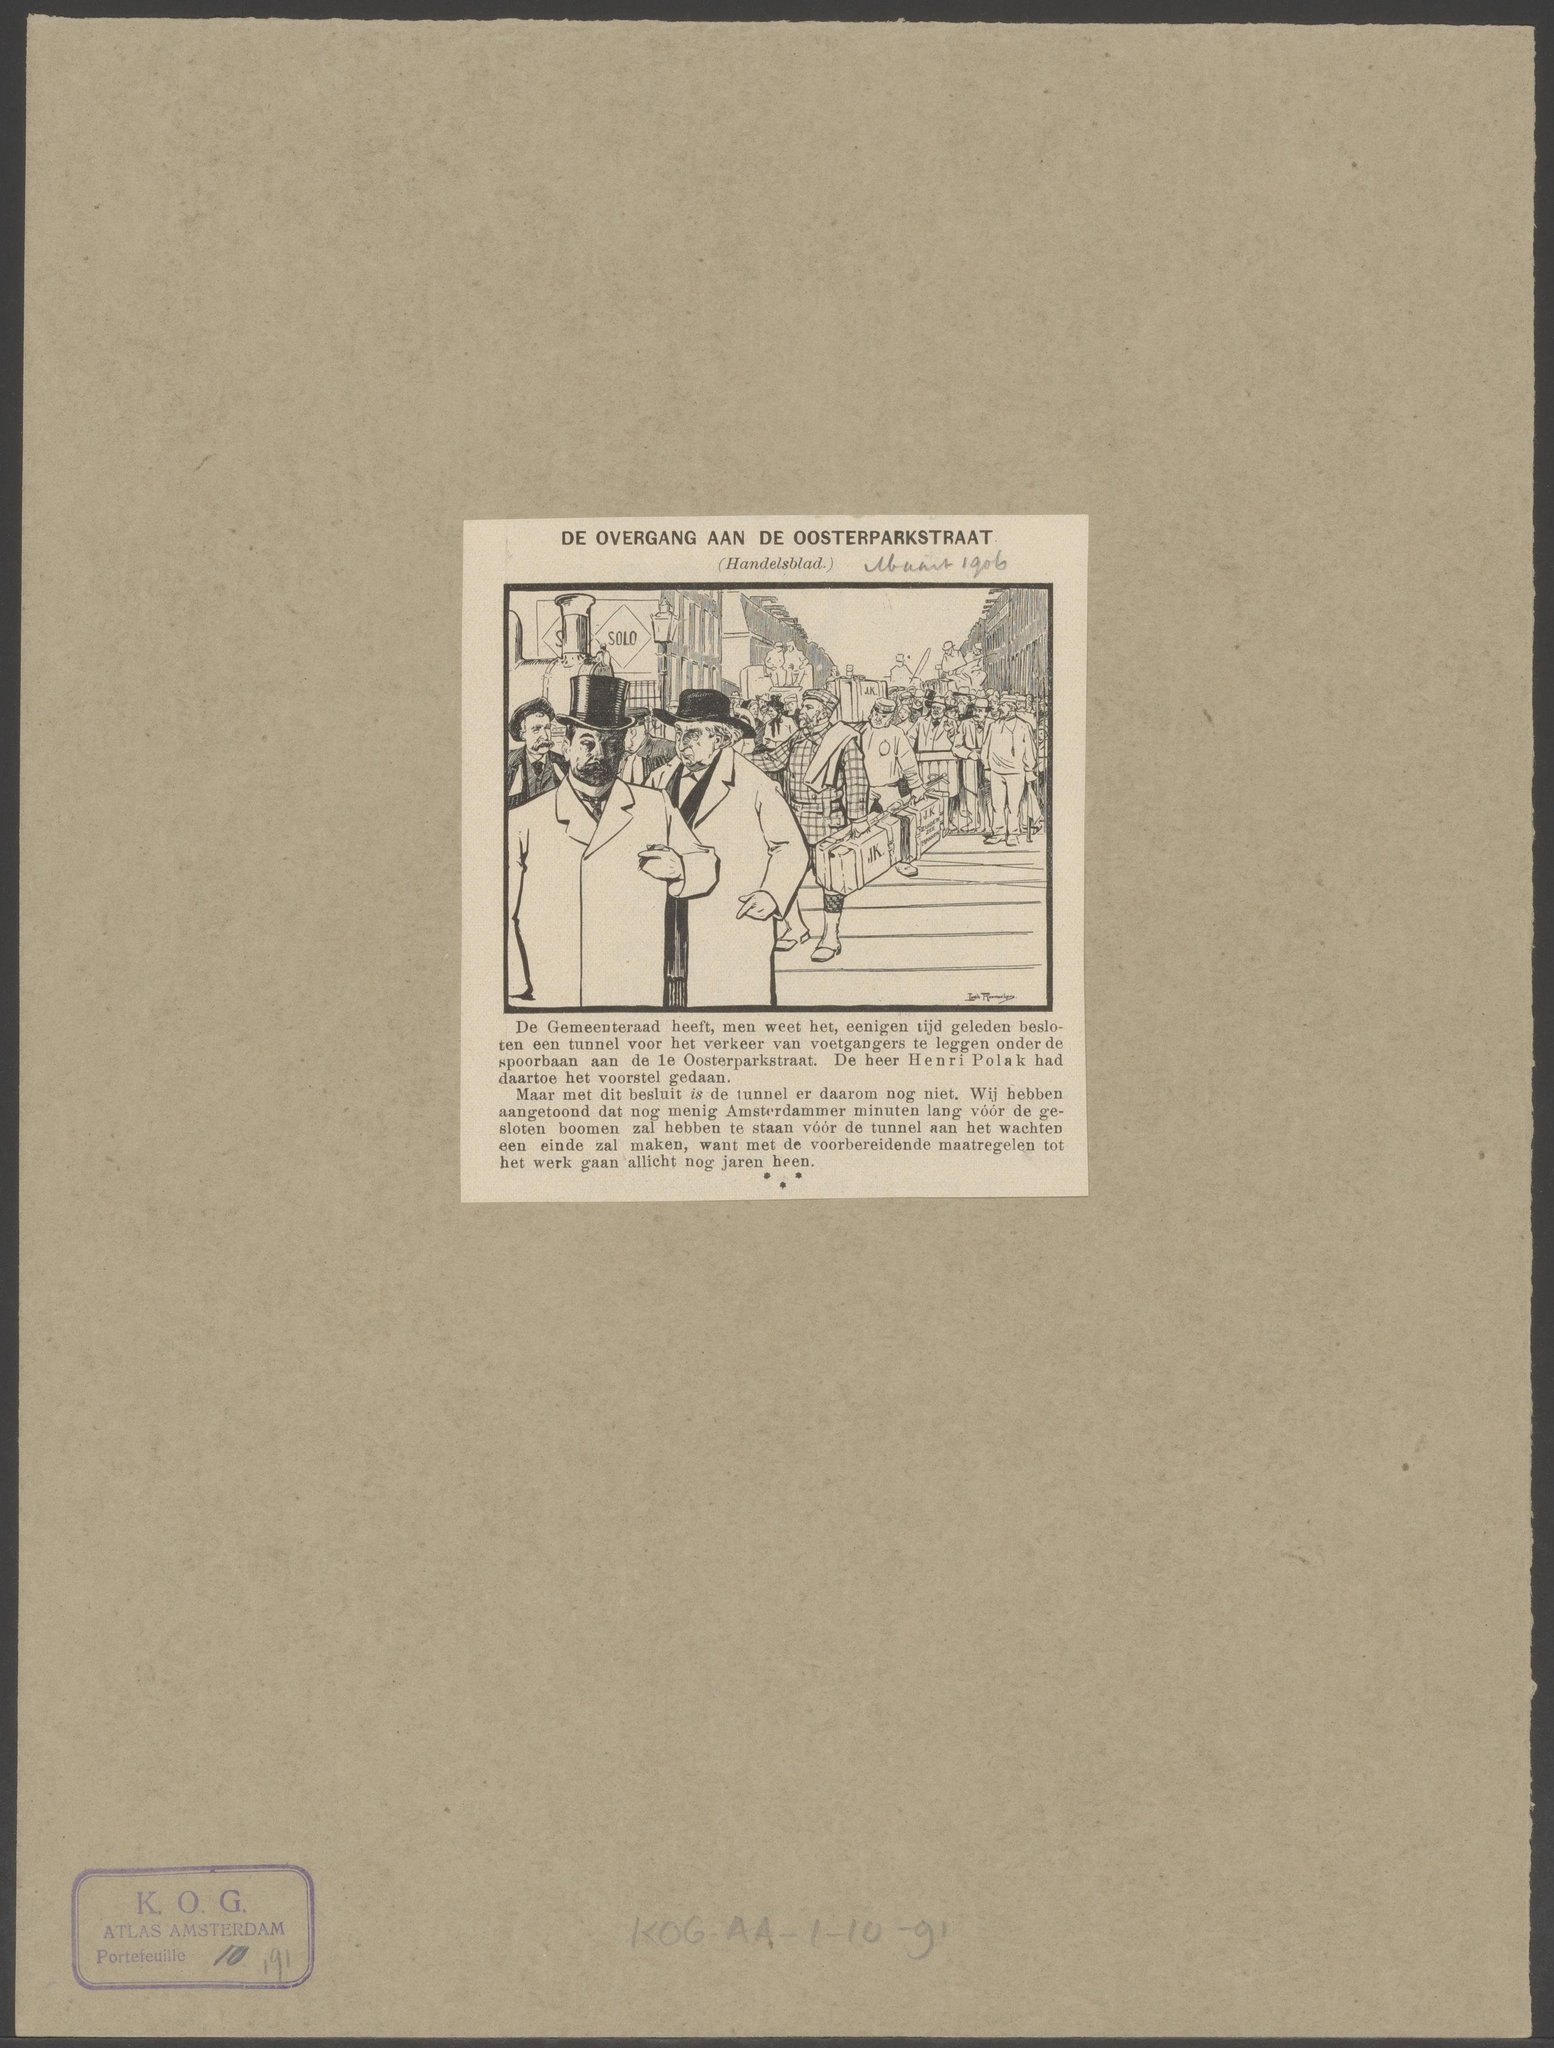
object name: print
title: Gezicht op de spoorwegovergang bij de Oosterparkstraat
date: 1903-1906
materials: paper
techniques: letterpress printing, line block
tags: city-view in general; 'veduta', railway, tramway; rack railway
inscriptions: collector's mark: ‘10,91’ Lugt 1641b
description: Onderwerpsrubriek binnen de Atlas Amsterdam: Oetgensstraat, Olifantspad, Olofspoort (St.), Onkelboerensteeg, Oosterparkstraat, Oostenburgergracht, Oosterdoksdijk, Osjessluis en Kalverstraat, Ossenspooksteeg, Oudekerksplein, Oudemanhuispoort, Oude Schans.